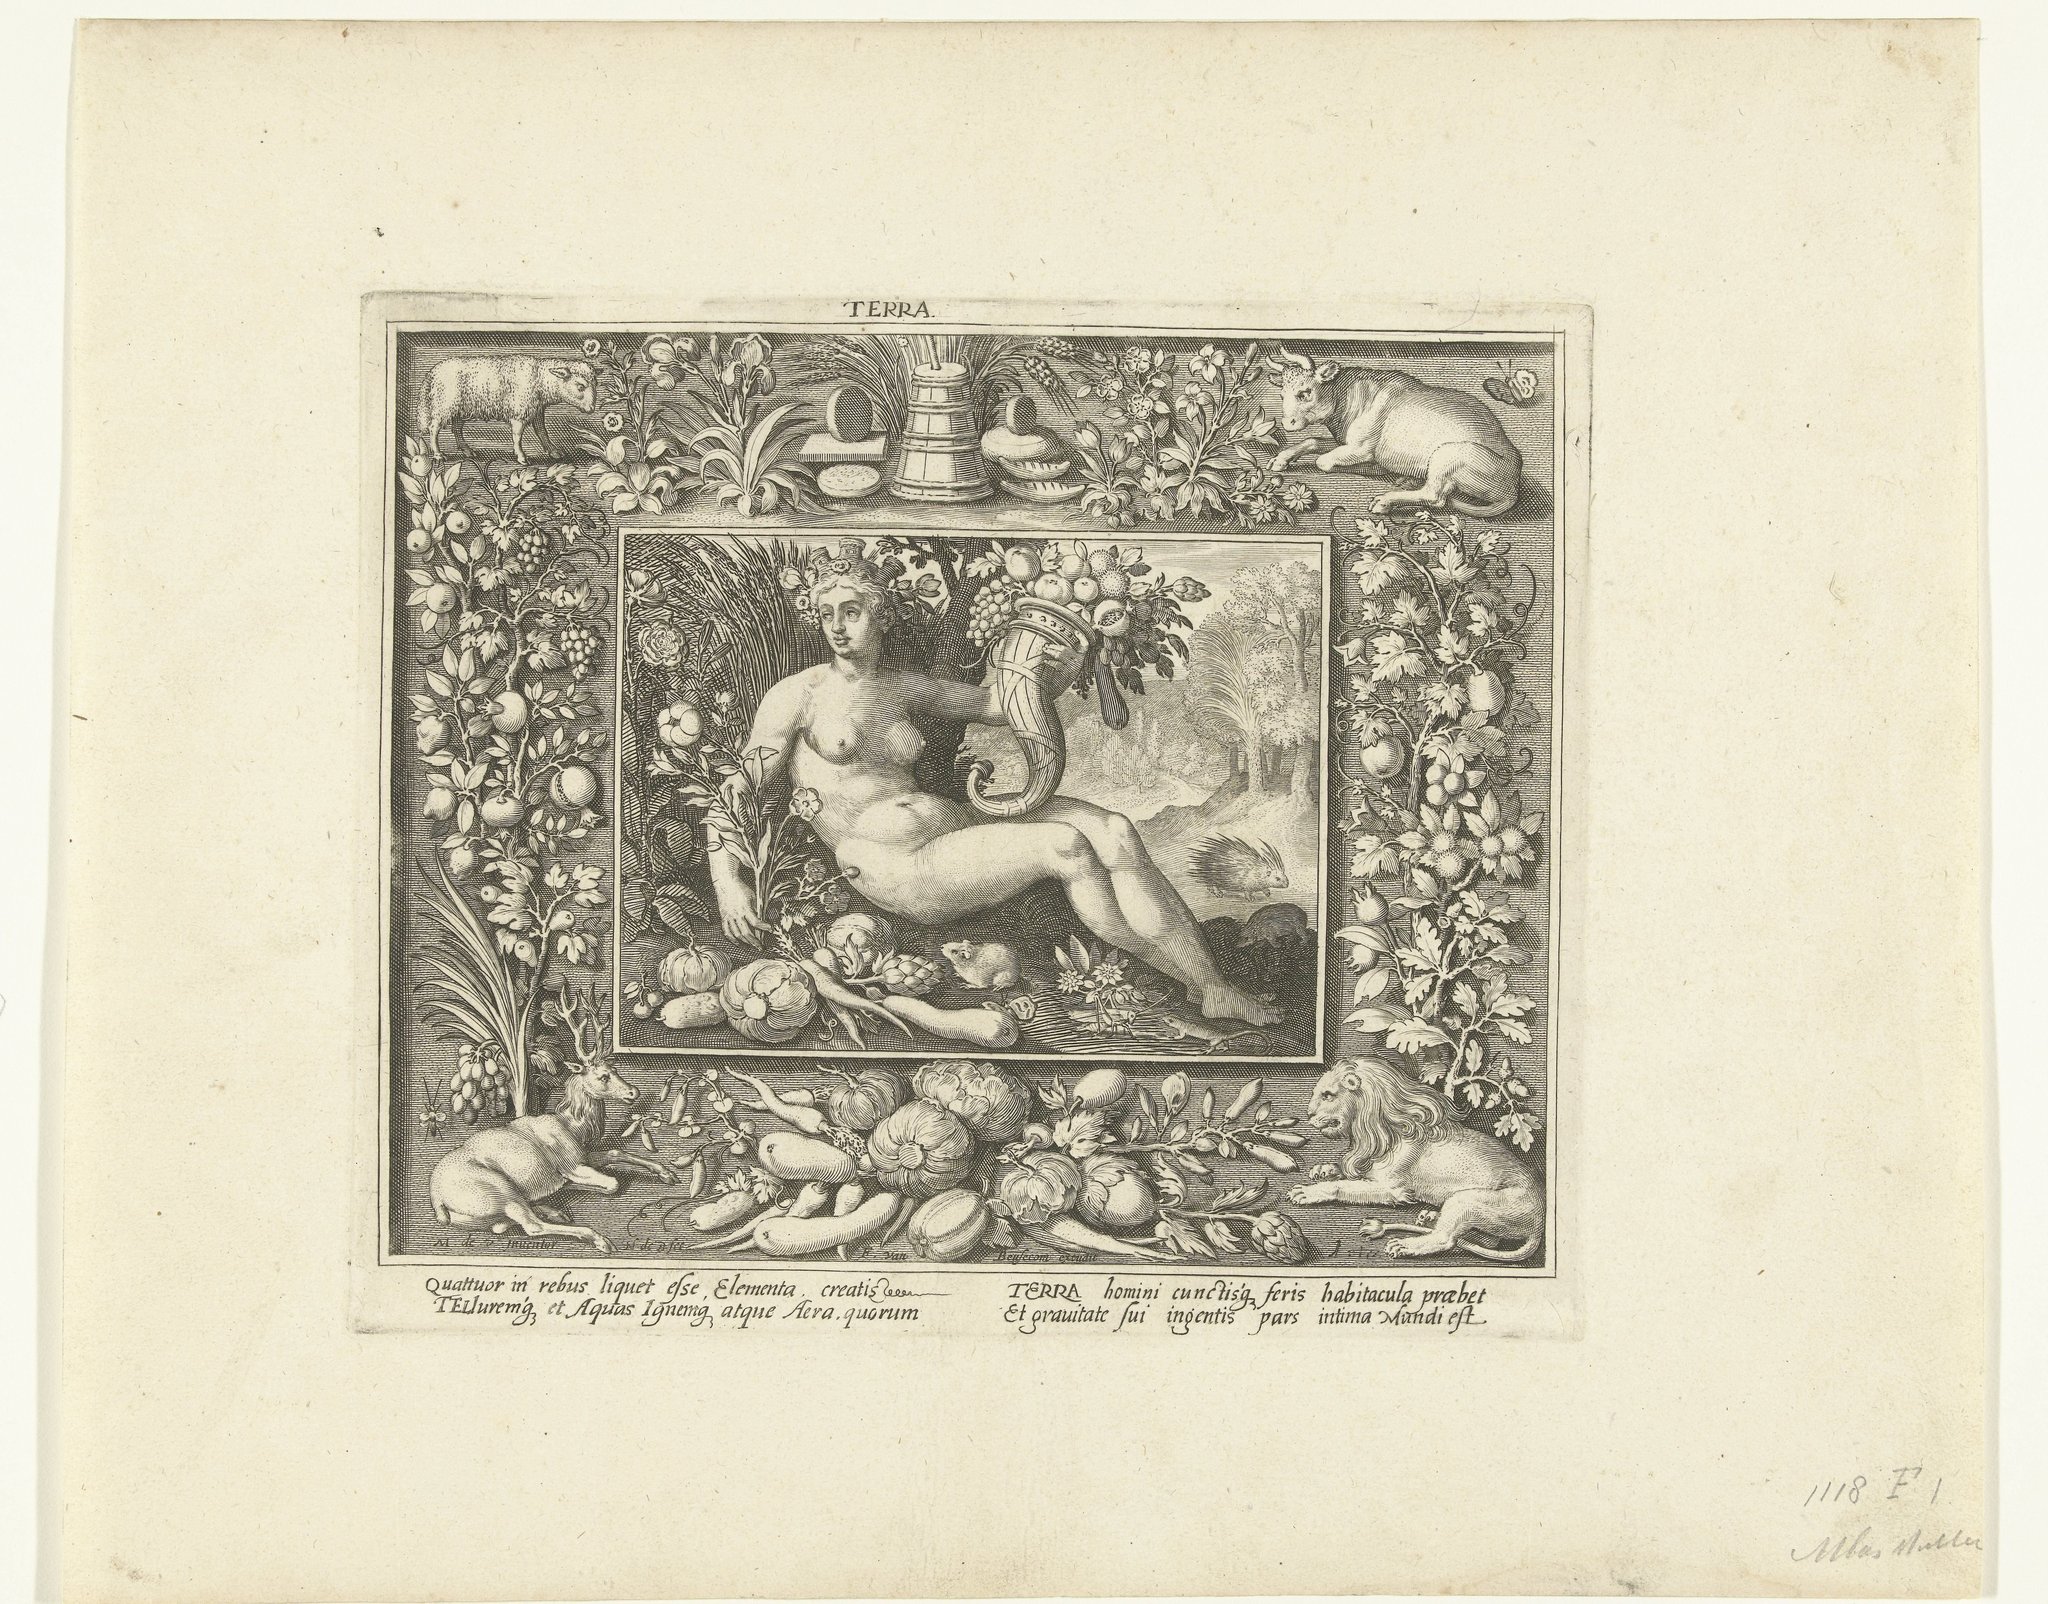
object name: print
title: Element Aarde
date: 1590-1603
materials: paper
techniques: engraving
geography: netherlands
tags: 'terra', 'carro della terra' (ripa)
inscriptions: collector's mark: Lugt 2228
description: Het element Aarde. Zittende naakte vrouwelijke personificatie met hoorn van overvloed. In een omlijsting met dieren, planten, bloemen, fruit, groente en producten van de landbouw en veeteelt. In het onderschrift een vers van 4 regels in het Latijn.